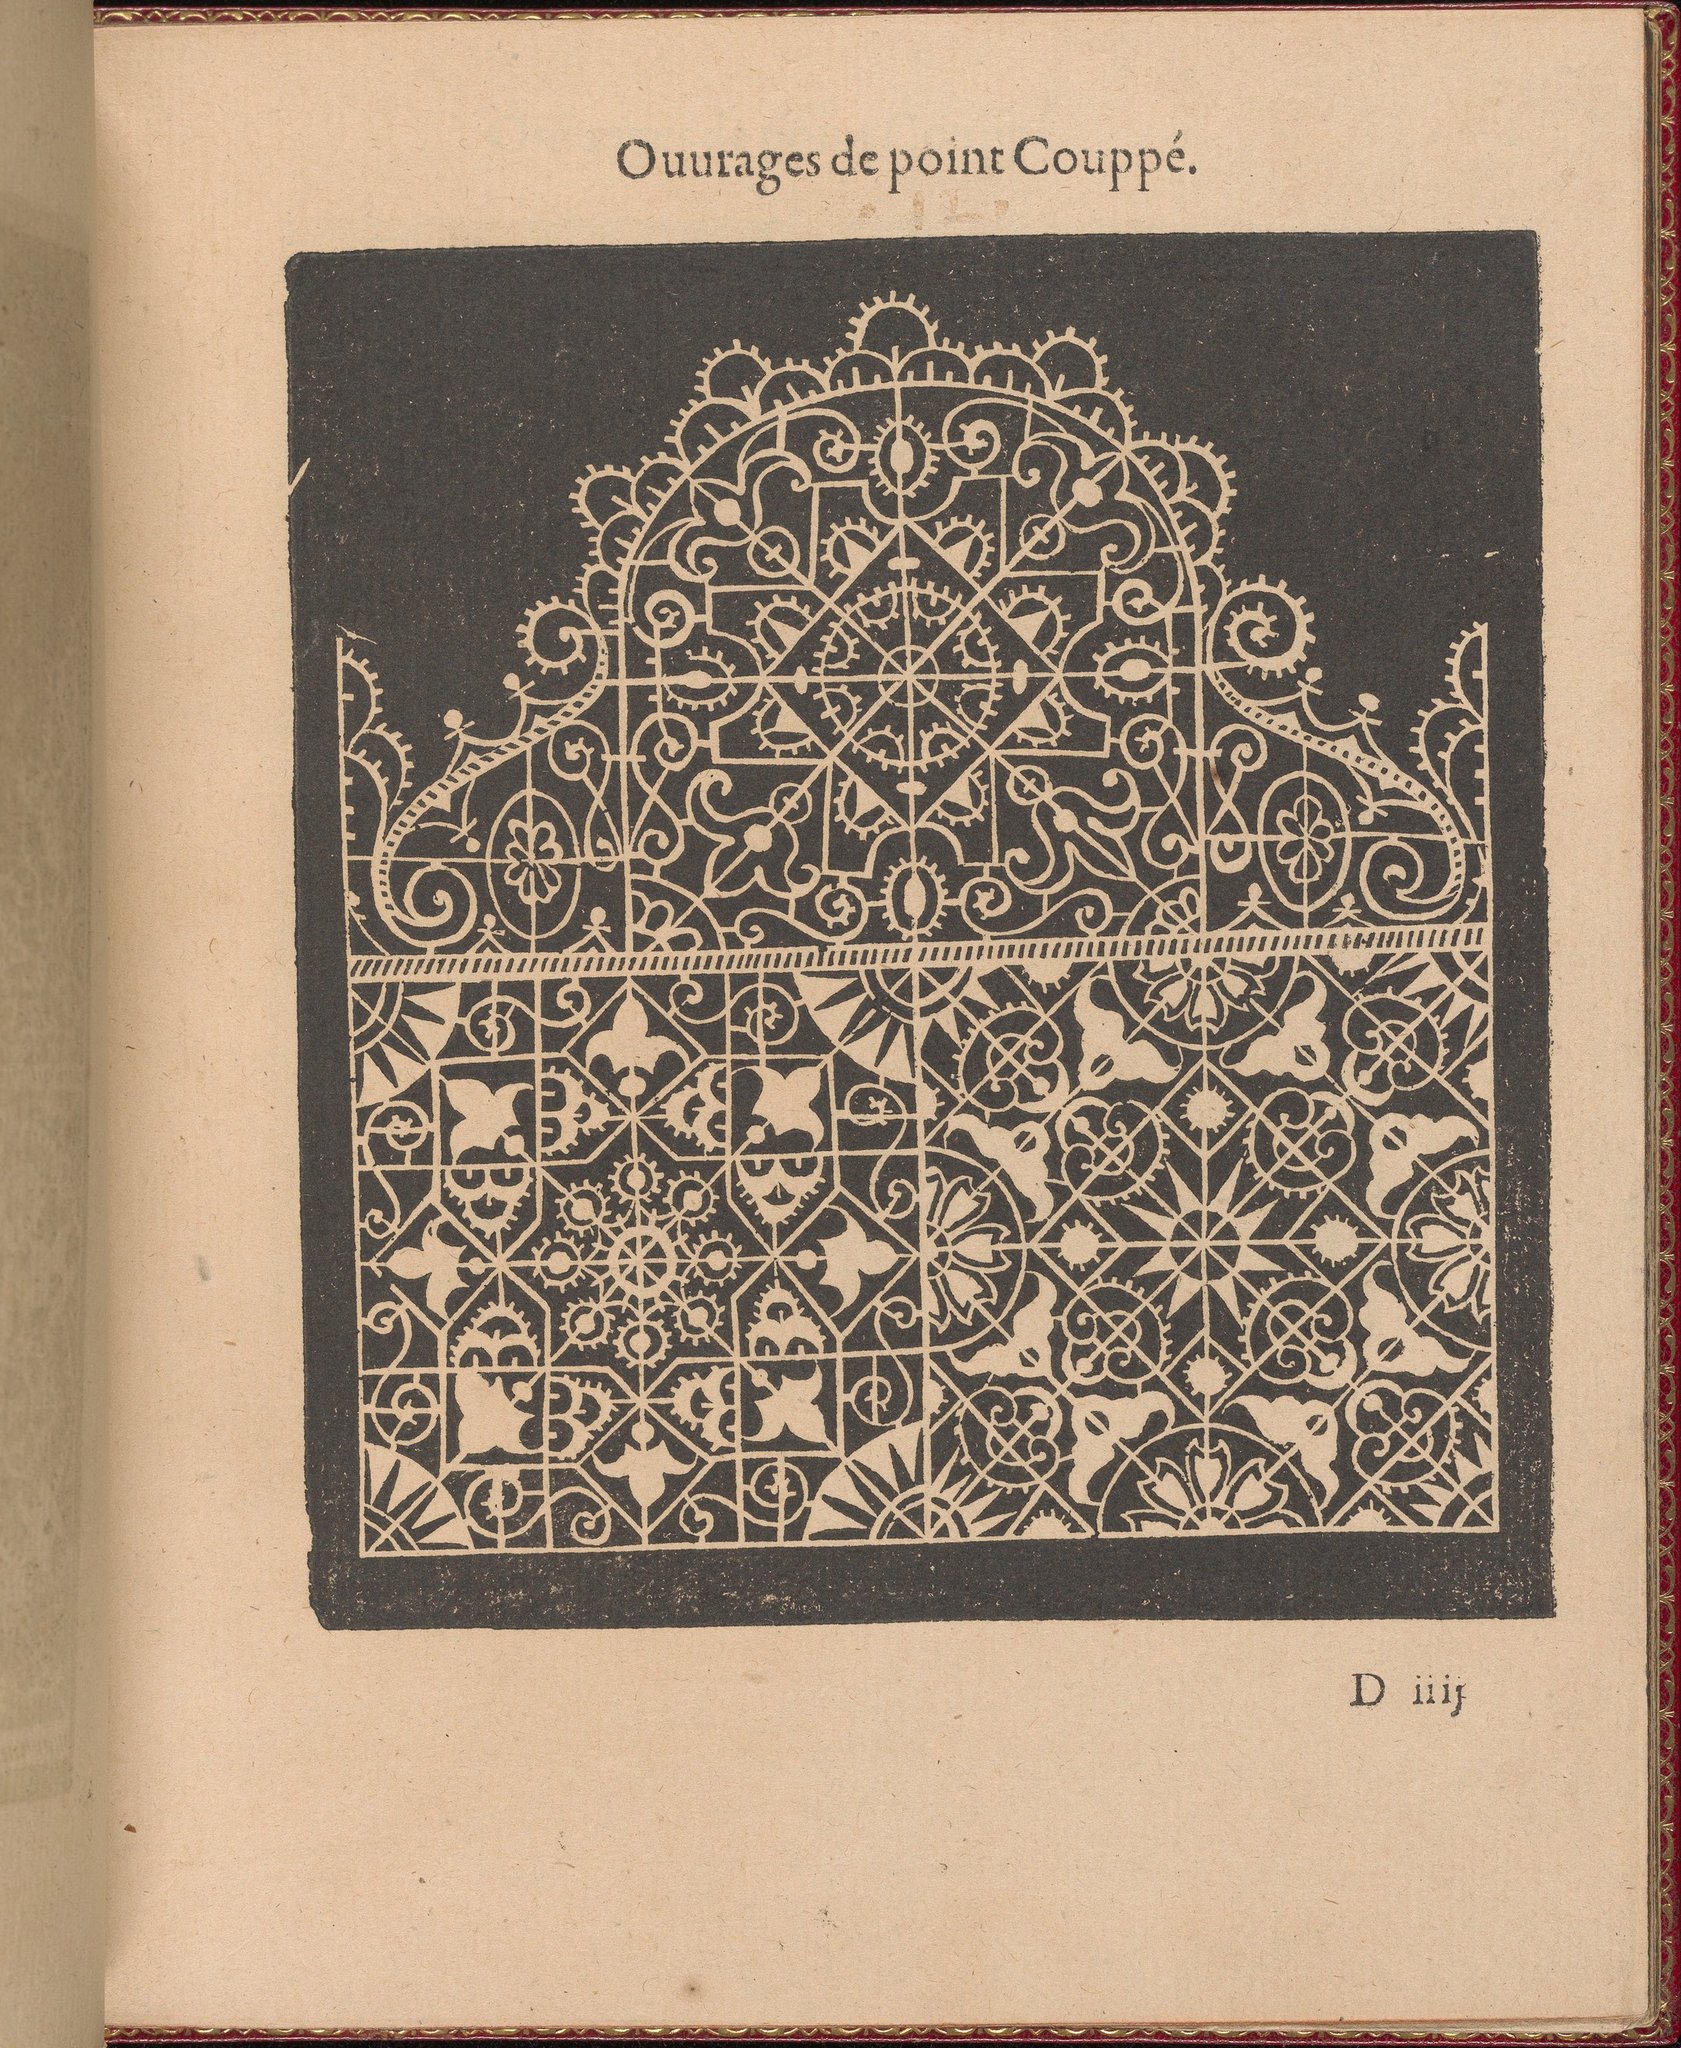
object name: book print ornament architecture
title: Les Singuliers et Nouveaux Portraicts... page 16 (recto)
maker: federico de vinciolo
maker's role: designer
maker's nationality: italian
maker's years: 1582-1599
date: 1588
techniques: woodcut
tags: ornament